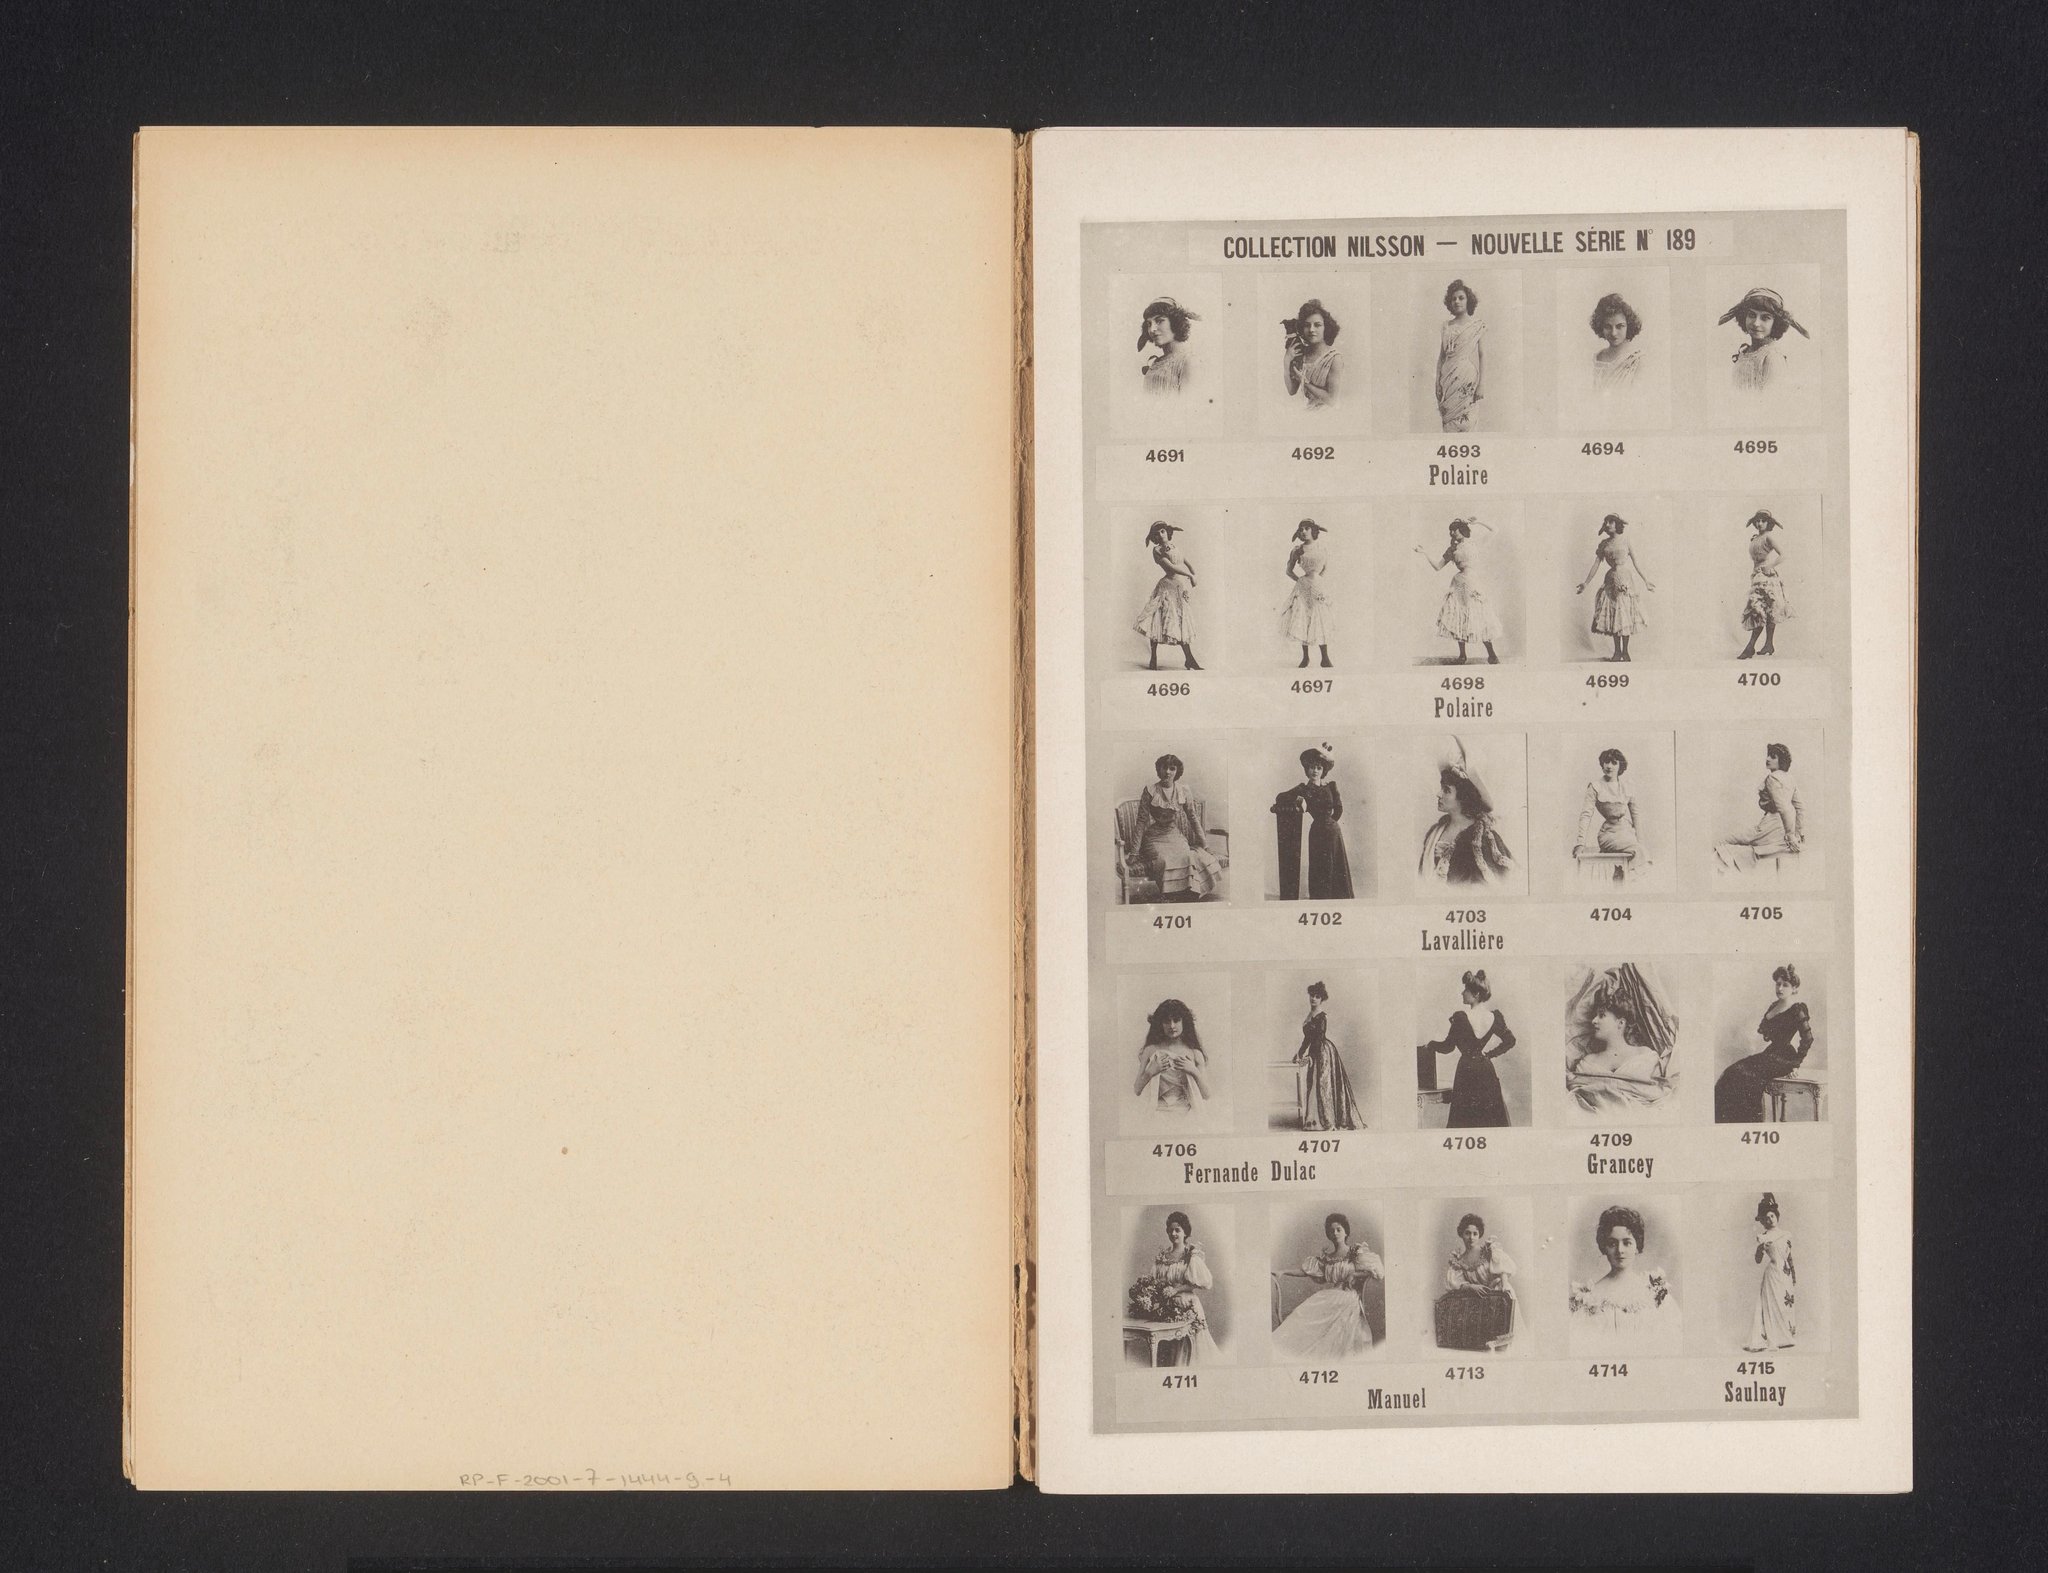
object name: page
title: 25 portretten van Polaire, Eve Lavallière, Fernande Dulac, Grancey, Manuel en Saulnay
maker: Anonymous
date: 1894-1899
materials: paper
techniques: photograph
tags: historical persons - bb - woman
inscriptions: number: ‘No 189’